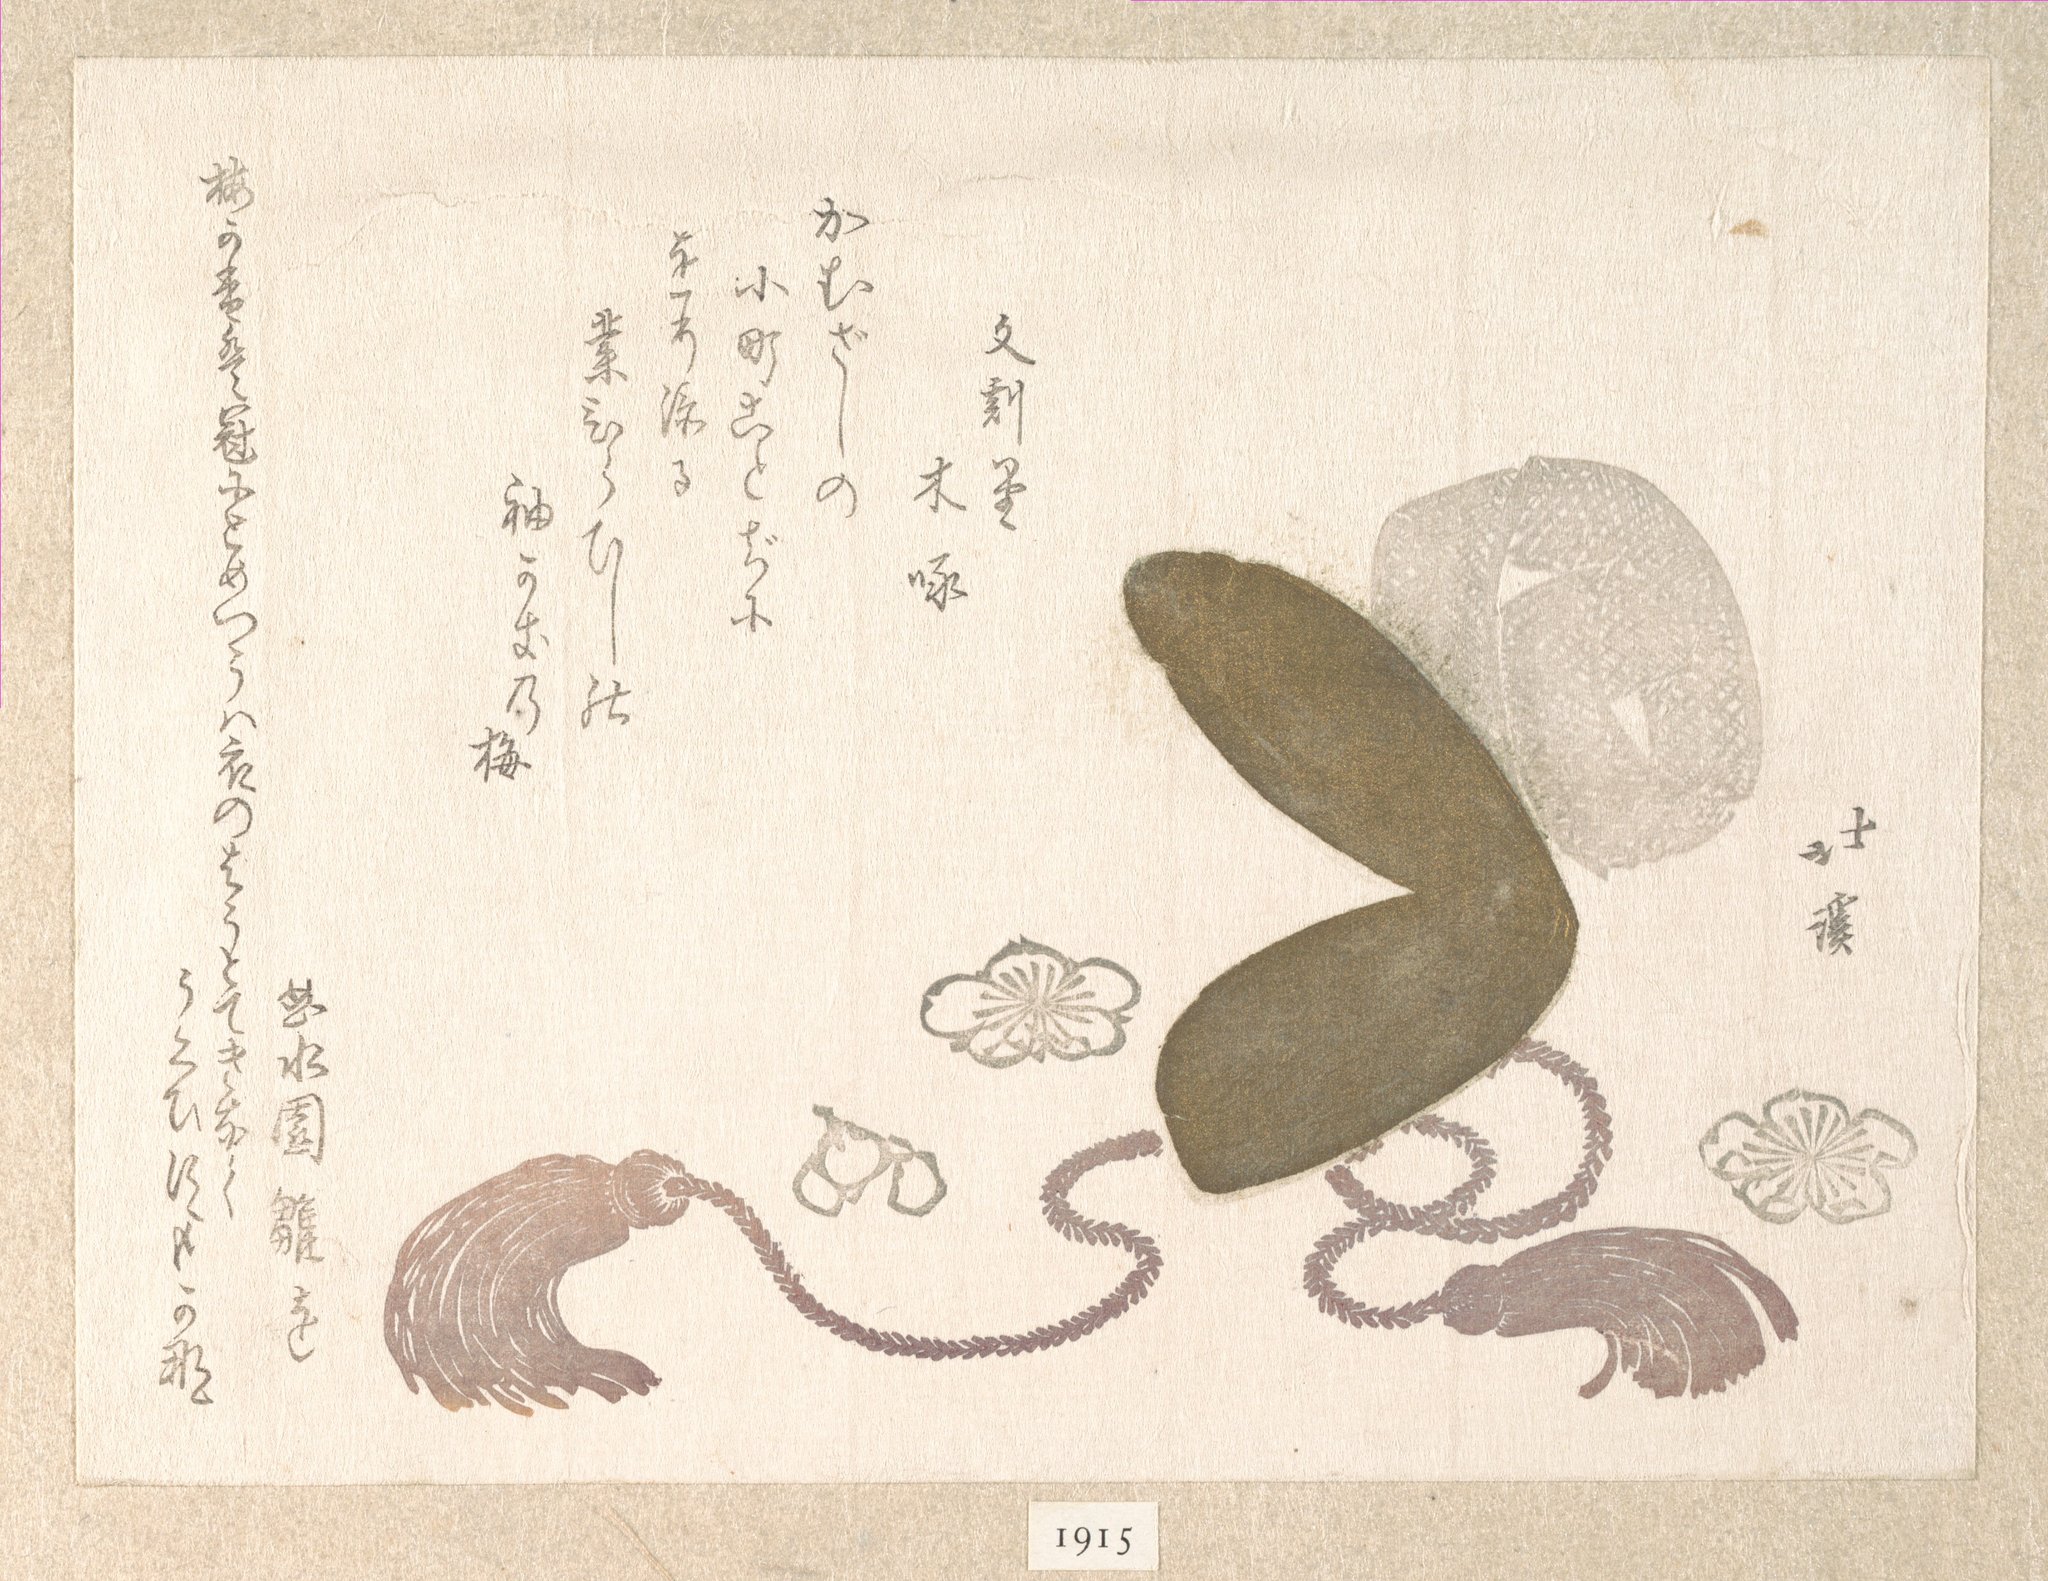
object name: print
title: Eboshi (a court hat)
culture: japanese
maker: totoya hokkei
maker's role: artist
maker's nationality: japanese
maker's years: 1780-1850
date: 1780-1850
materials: ink, paper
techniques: surimono, woodblock print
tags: hats